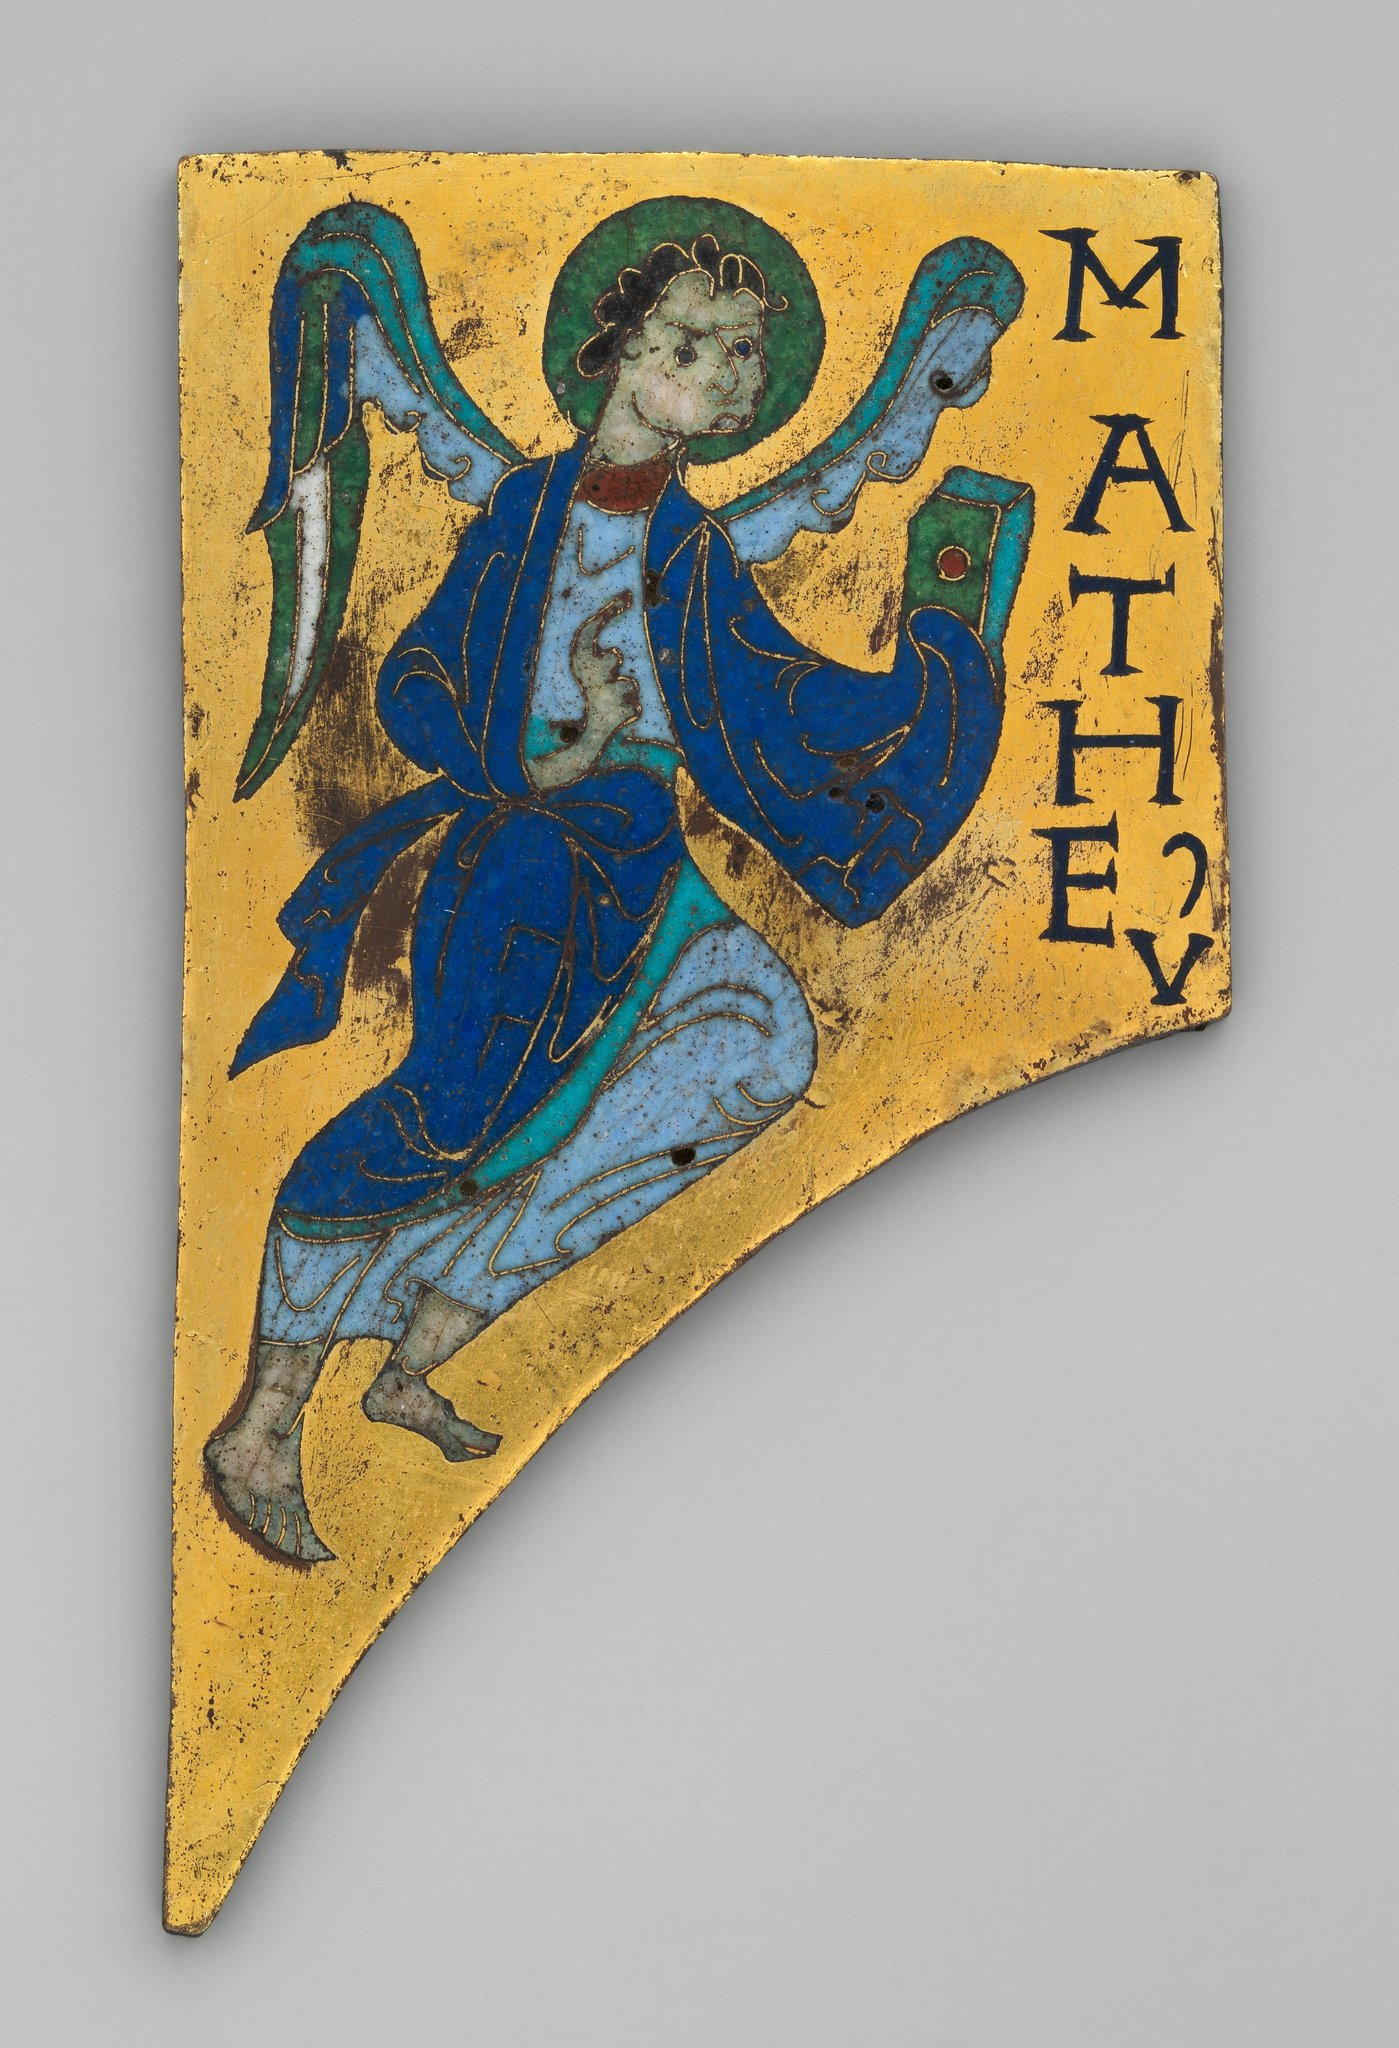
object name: plaque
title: Plaque with the Symbol of the Evangelist Matthew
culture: french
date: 1100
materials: copper, enamel, gilt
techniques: enamel, cutting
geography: france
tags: emblems